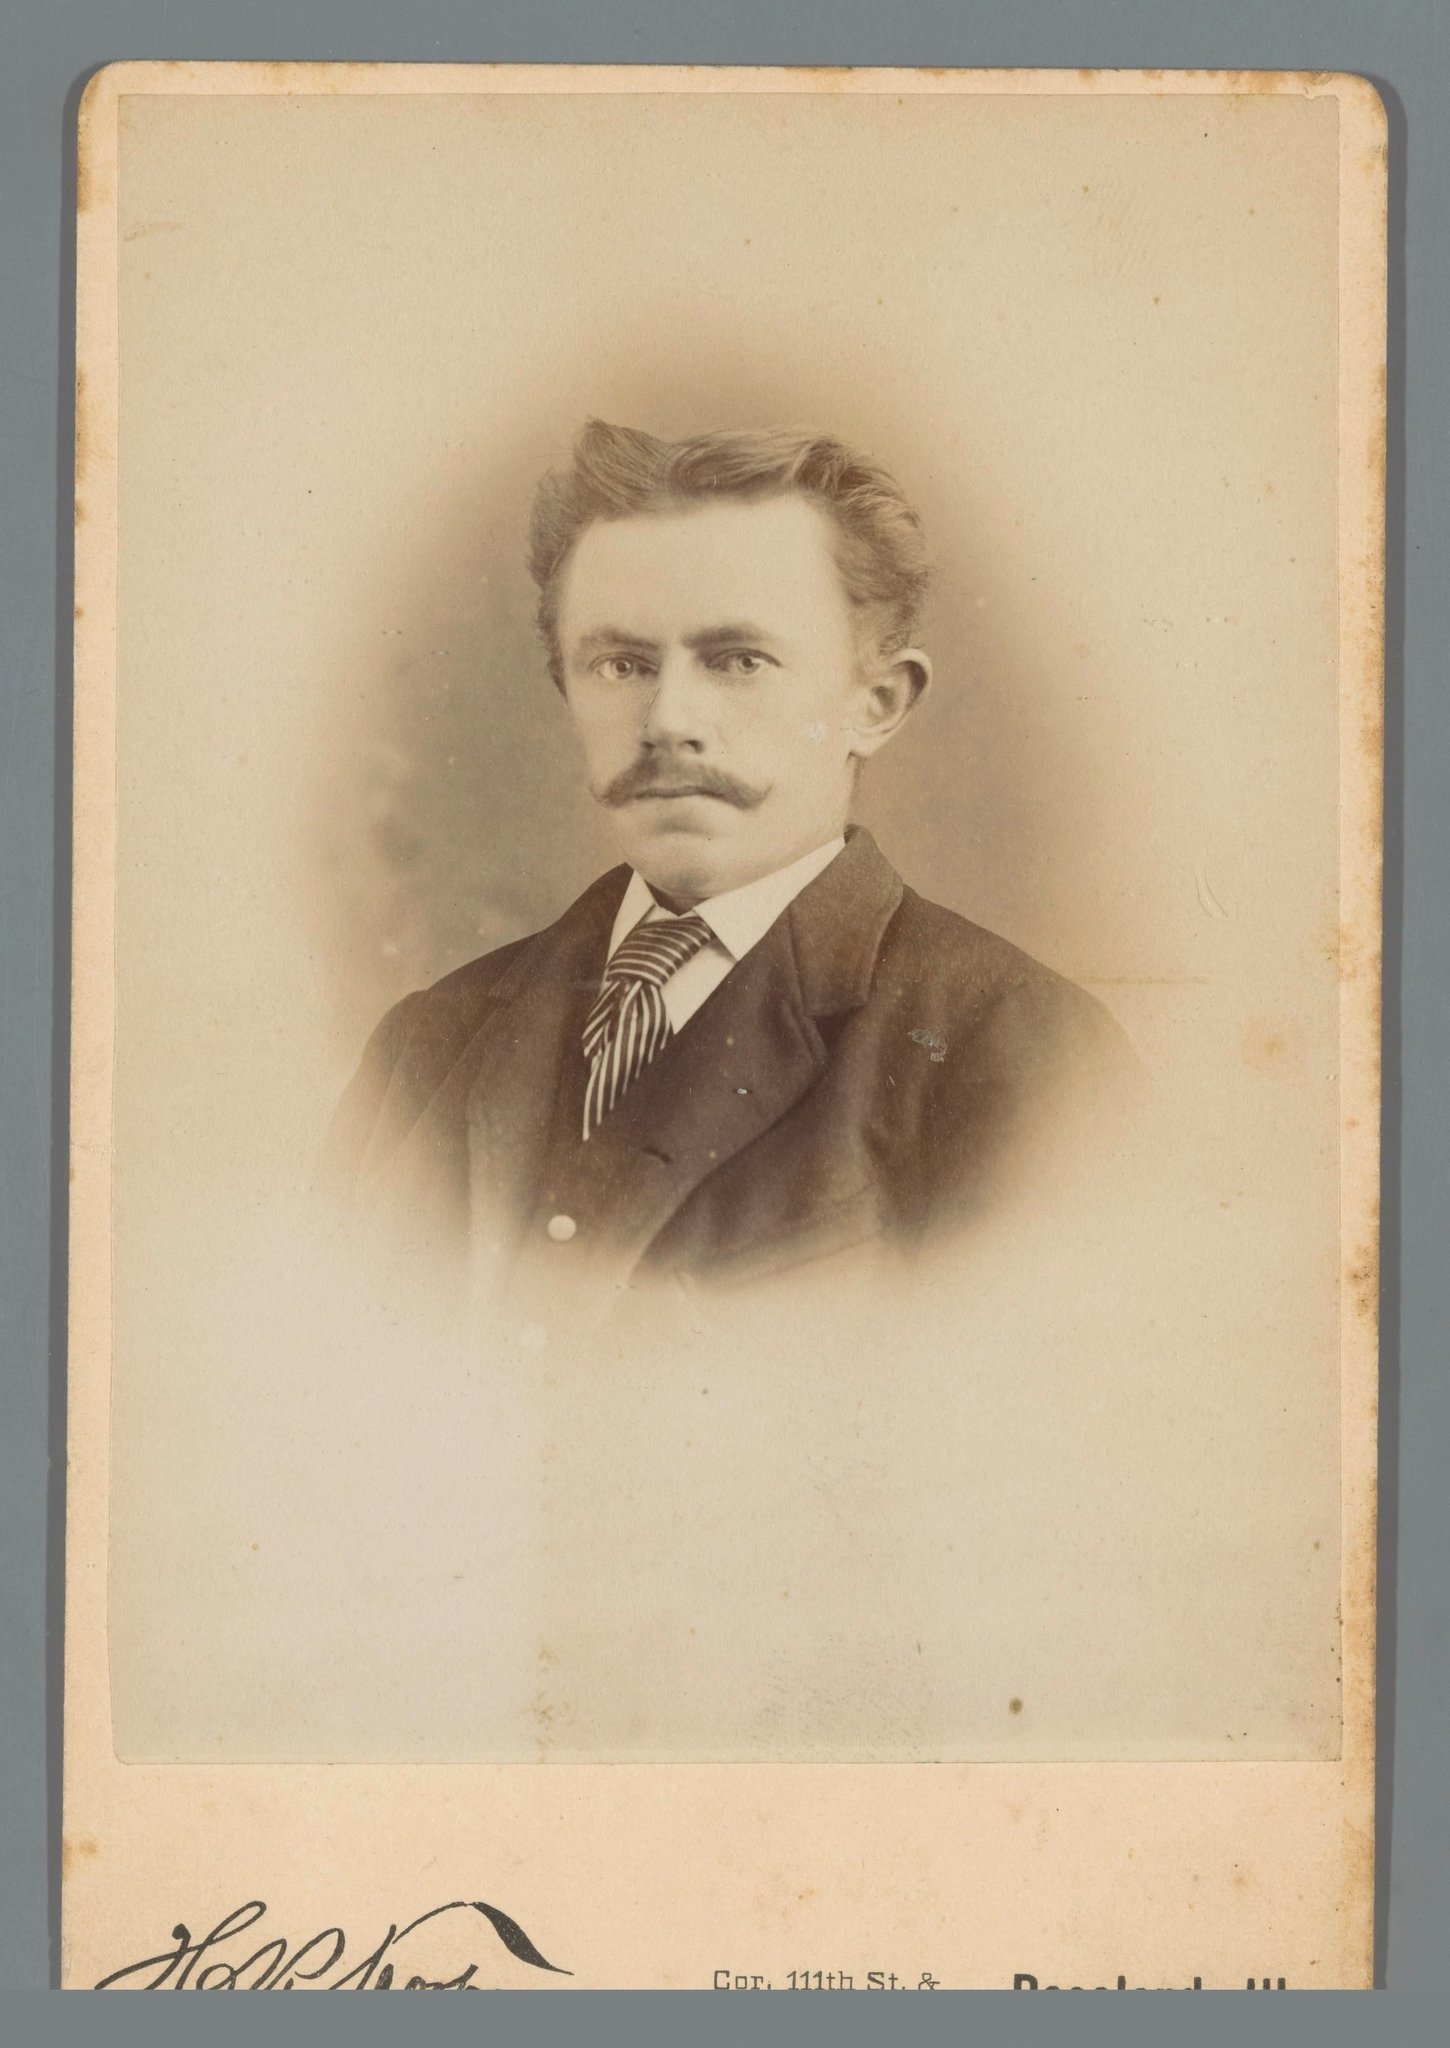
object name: cabinet photograph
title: Portret van Hieltje Postma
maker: h.r. koopman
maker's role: fotograaf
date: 1880-1910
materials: cardboard, photographic support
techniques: albumen print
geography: illinois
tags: adult man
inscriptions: inscription: ‘Hieltje Postma overleden in Amerika. zoon van tante Aafke A[...]’